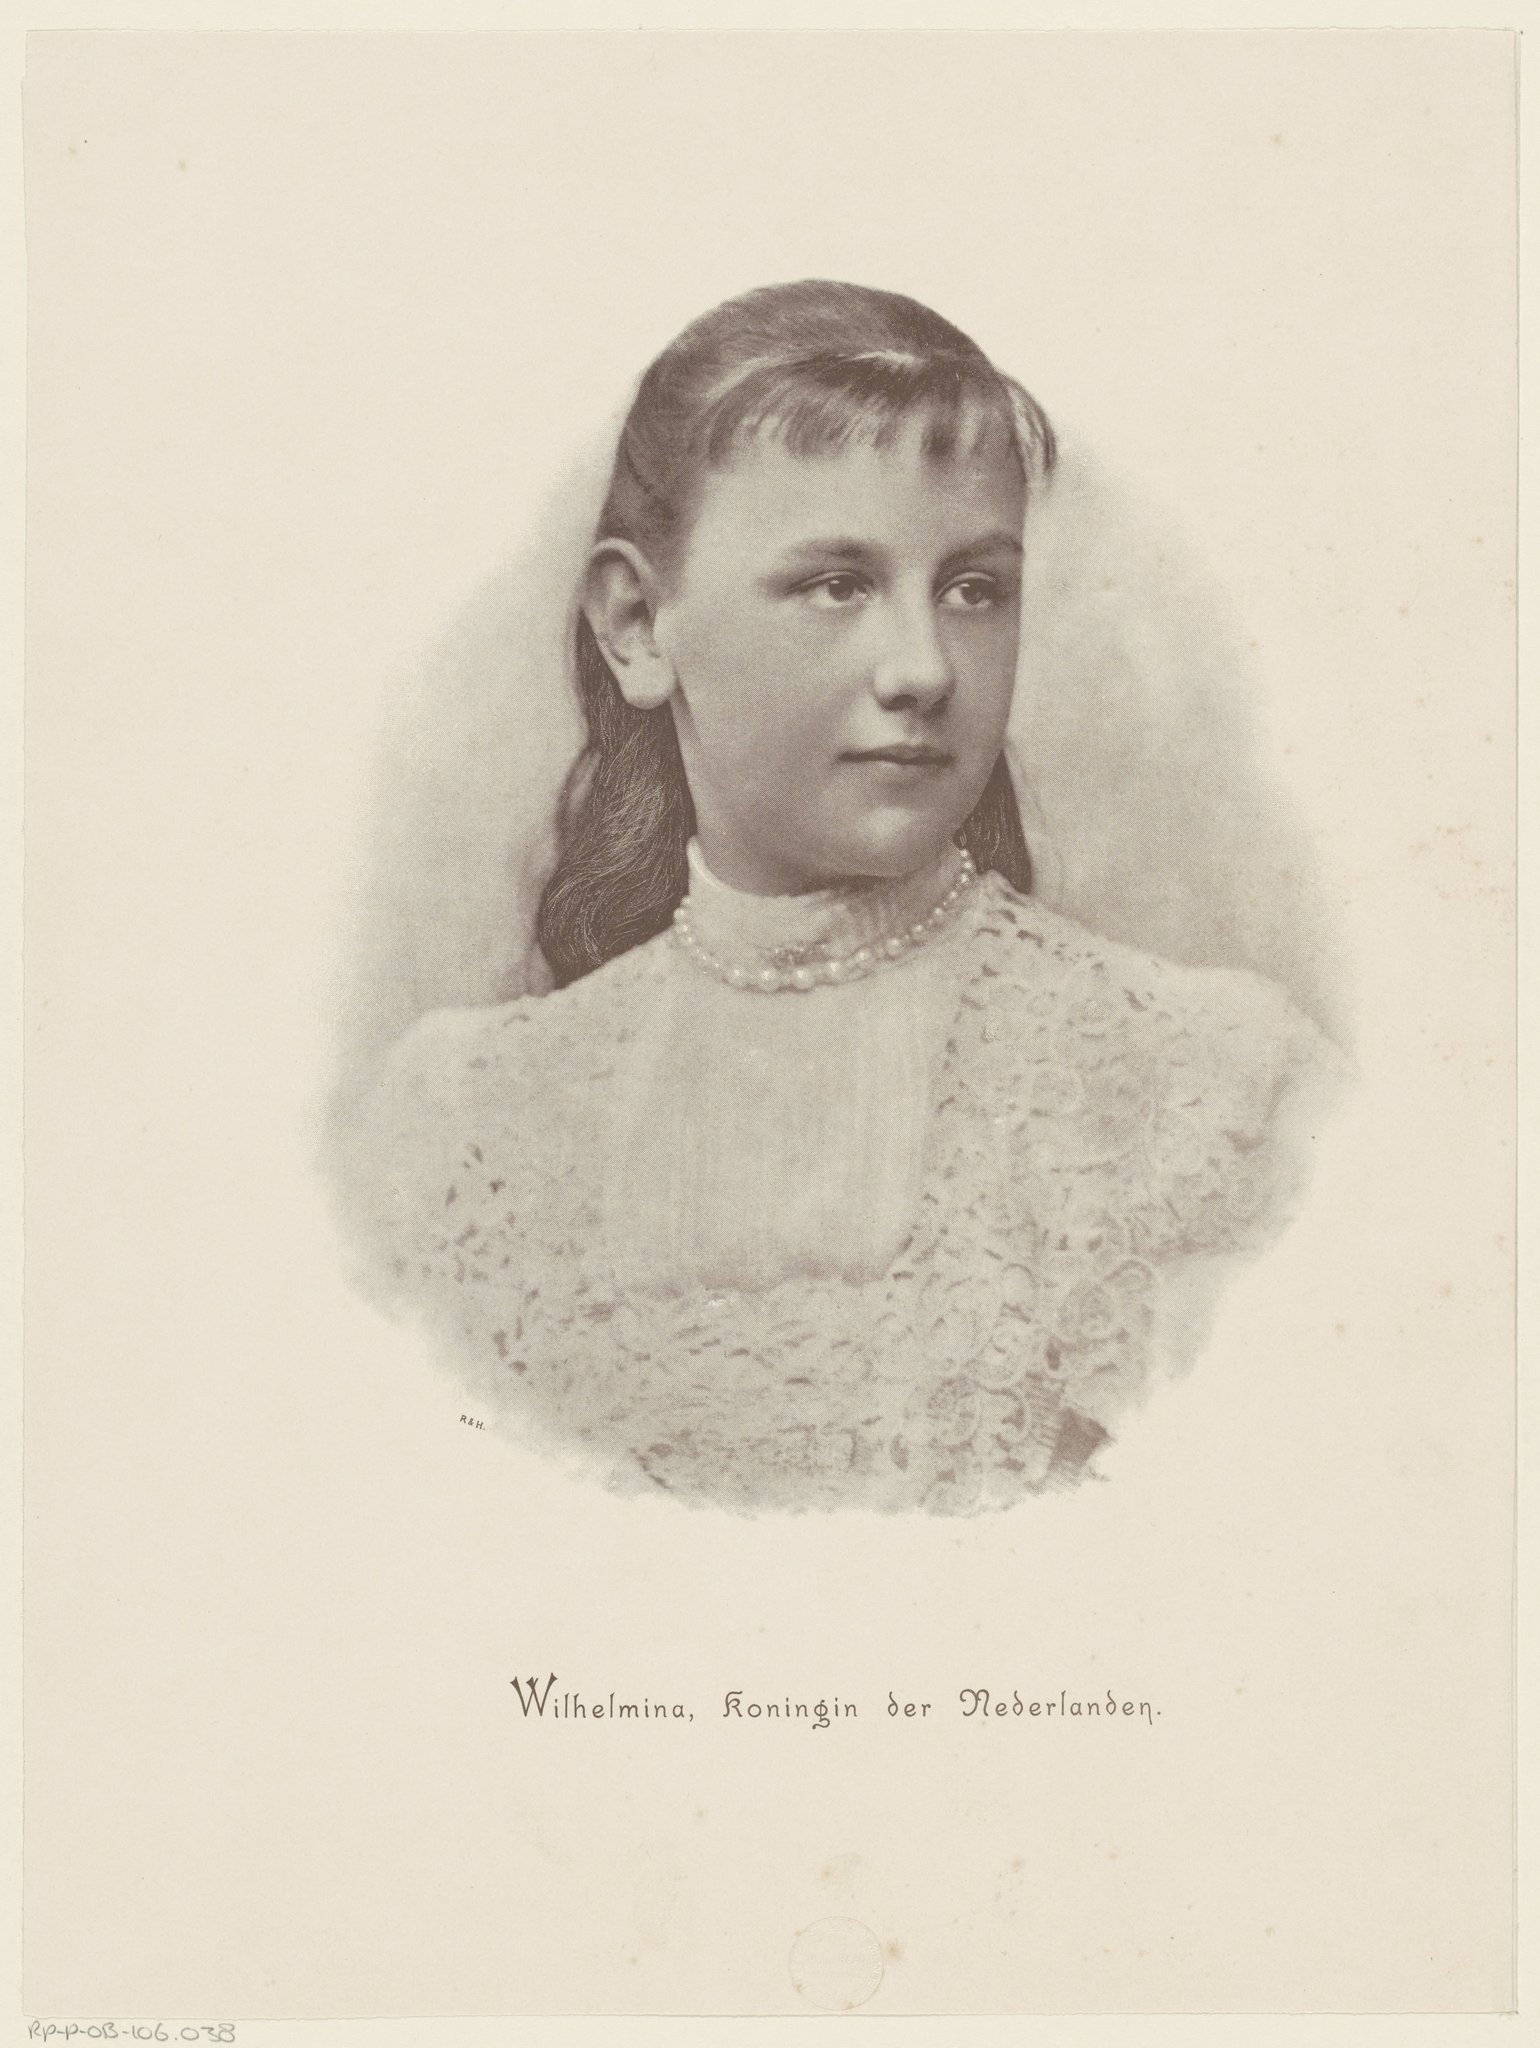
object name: photomechanical print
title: Portret van Wilhelmina, koningin der Nederlanden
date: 1890-1895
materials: paper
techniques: photochemical processes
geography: the hague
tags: the hague, print maker, wilhelmina of the netherlands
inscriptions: check stamp: ‘M.J. DE HAAN 'S GRAVENHAGE BOEK- KUNST- & MUZIEKHANDEL’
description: De hier vermelde titel verwijst naar de hoogst verkregen titel van de geportretteerde, niet per se naar de titel die de geportretteerde op deze voorstelling draagt.